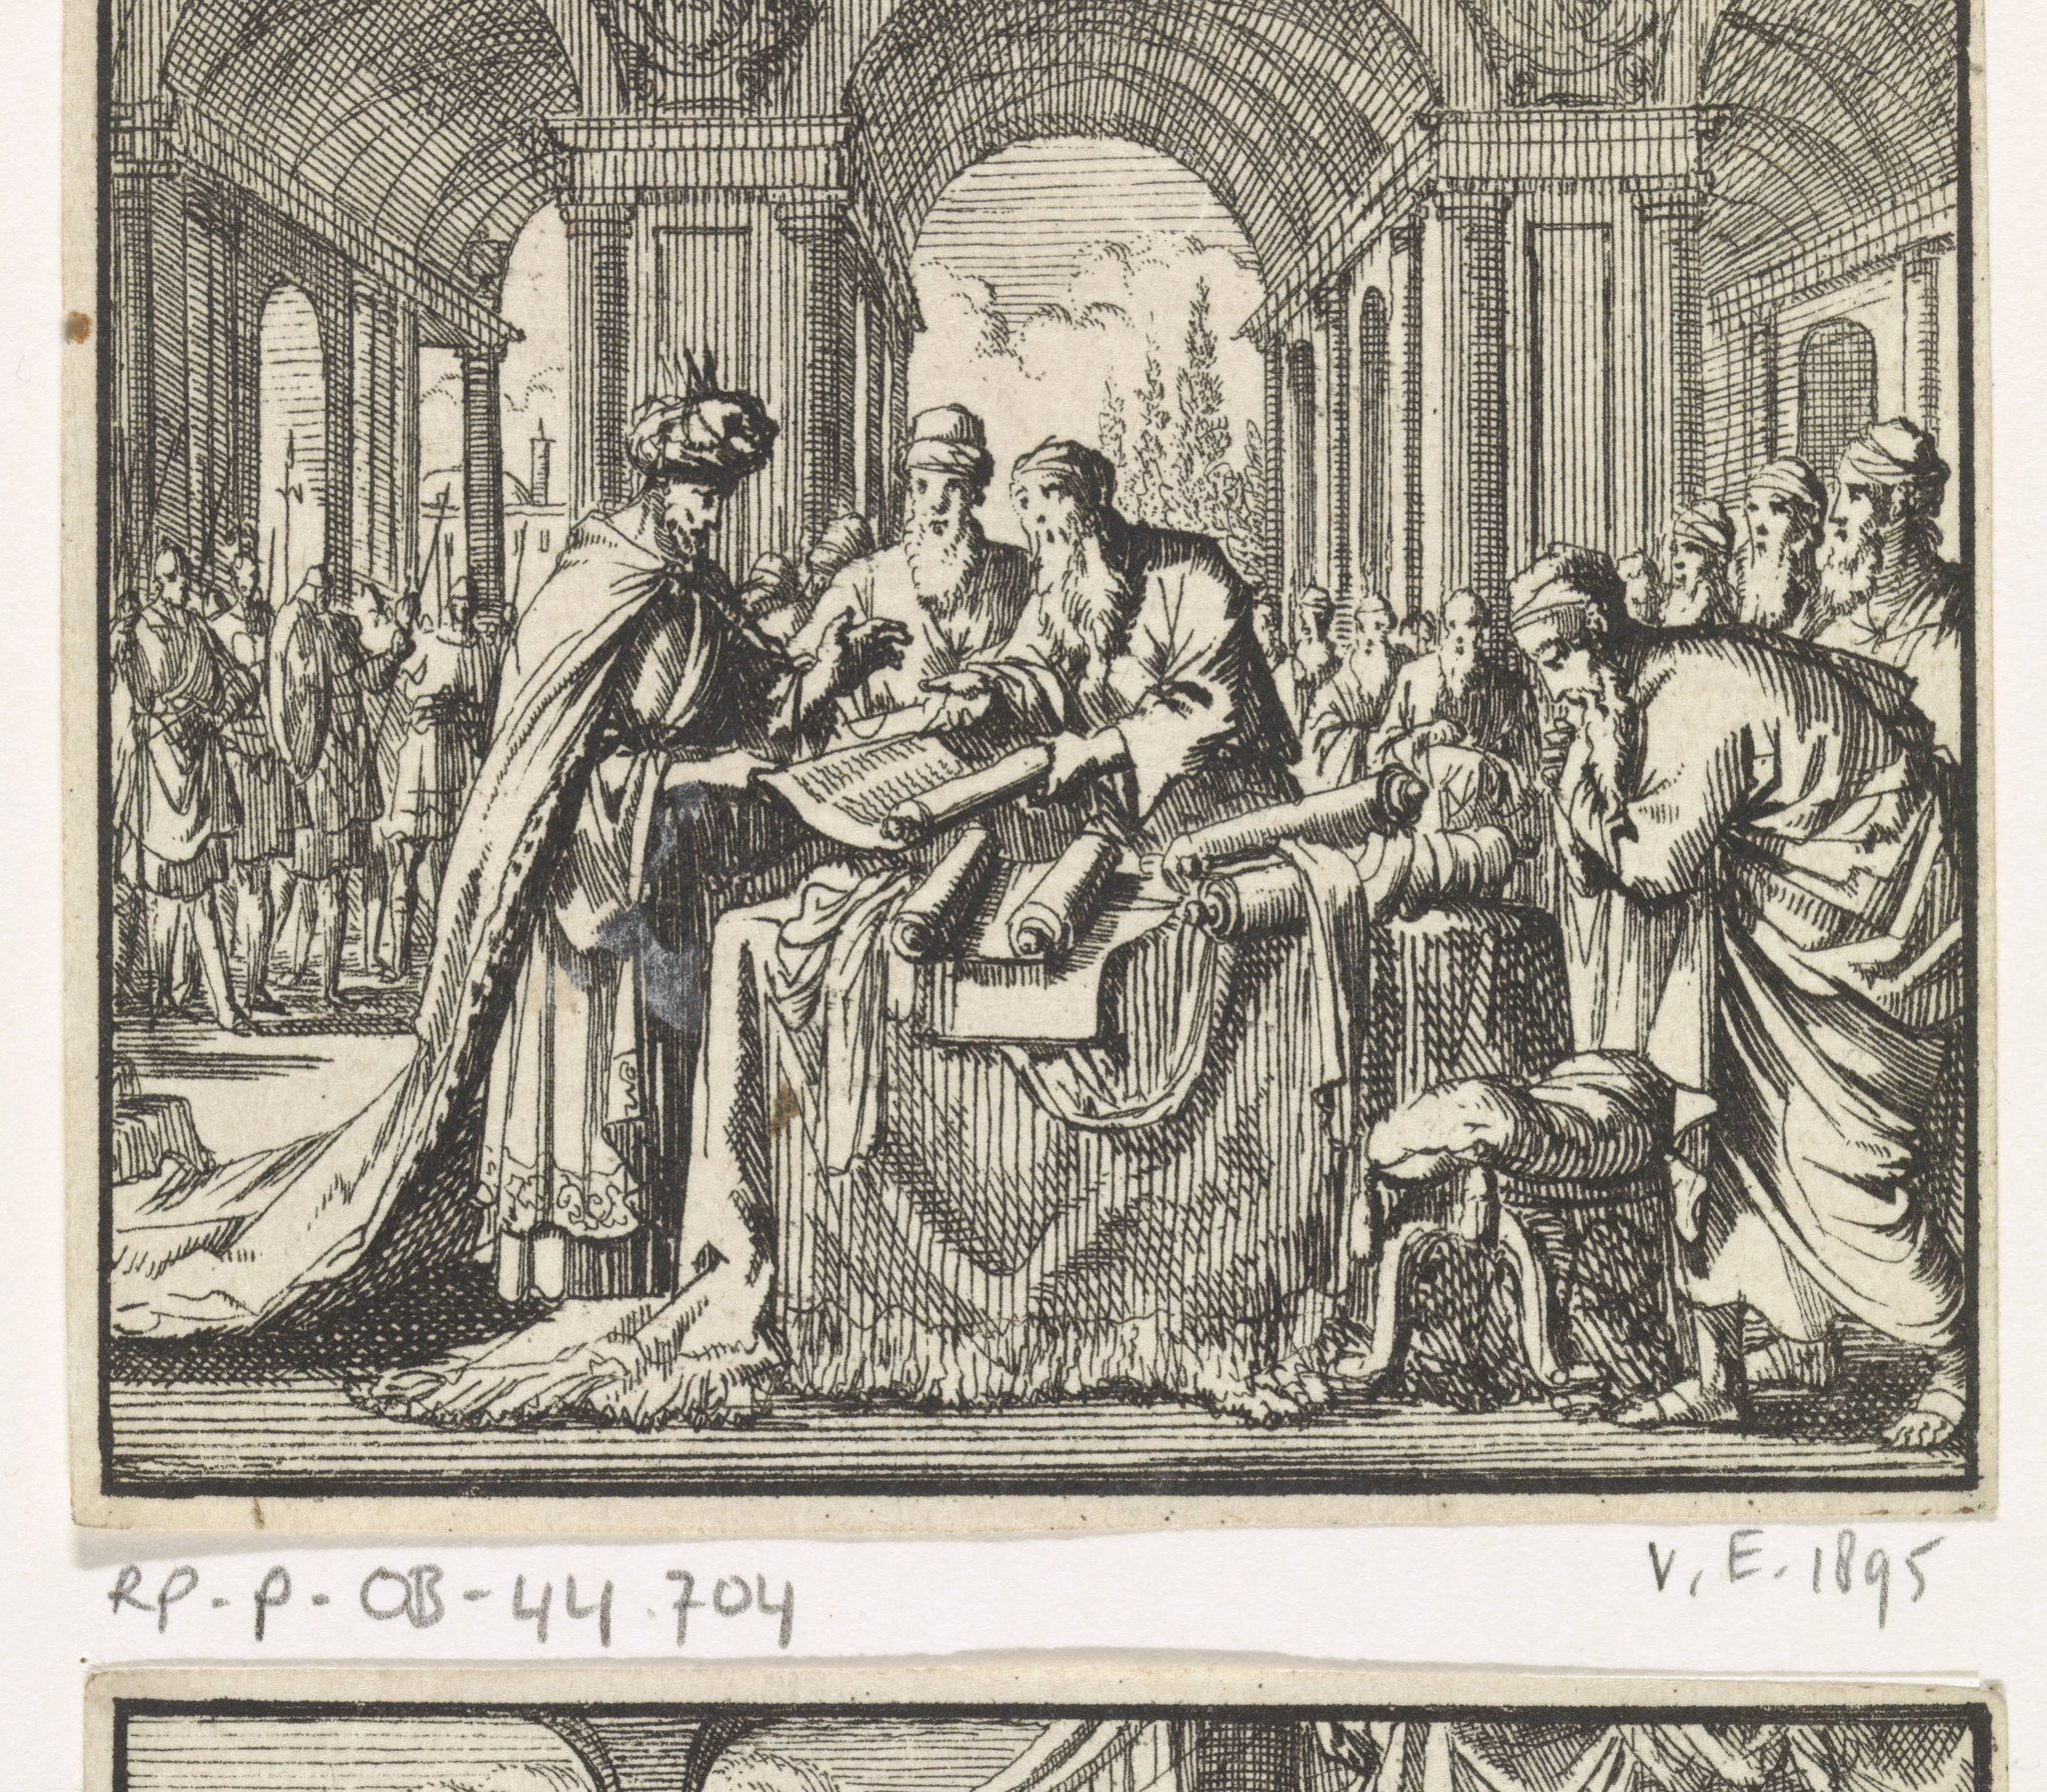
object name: print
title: Koning Ptolemaeus Philadelphus bestudeert de Hebreeuwse wetsrollen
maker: jan luyken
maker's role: draughtsman, print maker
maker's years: 1649-1712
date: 1698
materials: paper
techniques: etching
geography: amsterdam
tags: (story of) ptolemy philadelphus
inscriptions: collector's mark: Lugt 2228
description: Proefdruk van illustratie uit: Josephus, Flavius. XX. boeken van de oude geschiedenissen der joden, 4 delen. Amsterdam: Barent Visscher, Willem de Coup, Willem van Lamsveld, Andries van Damme, 1698, dl. II.